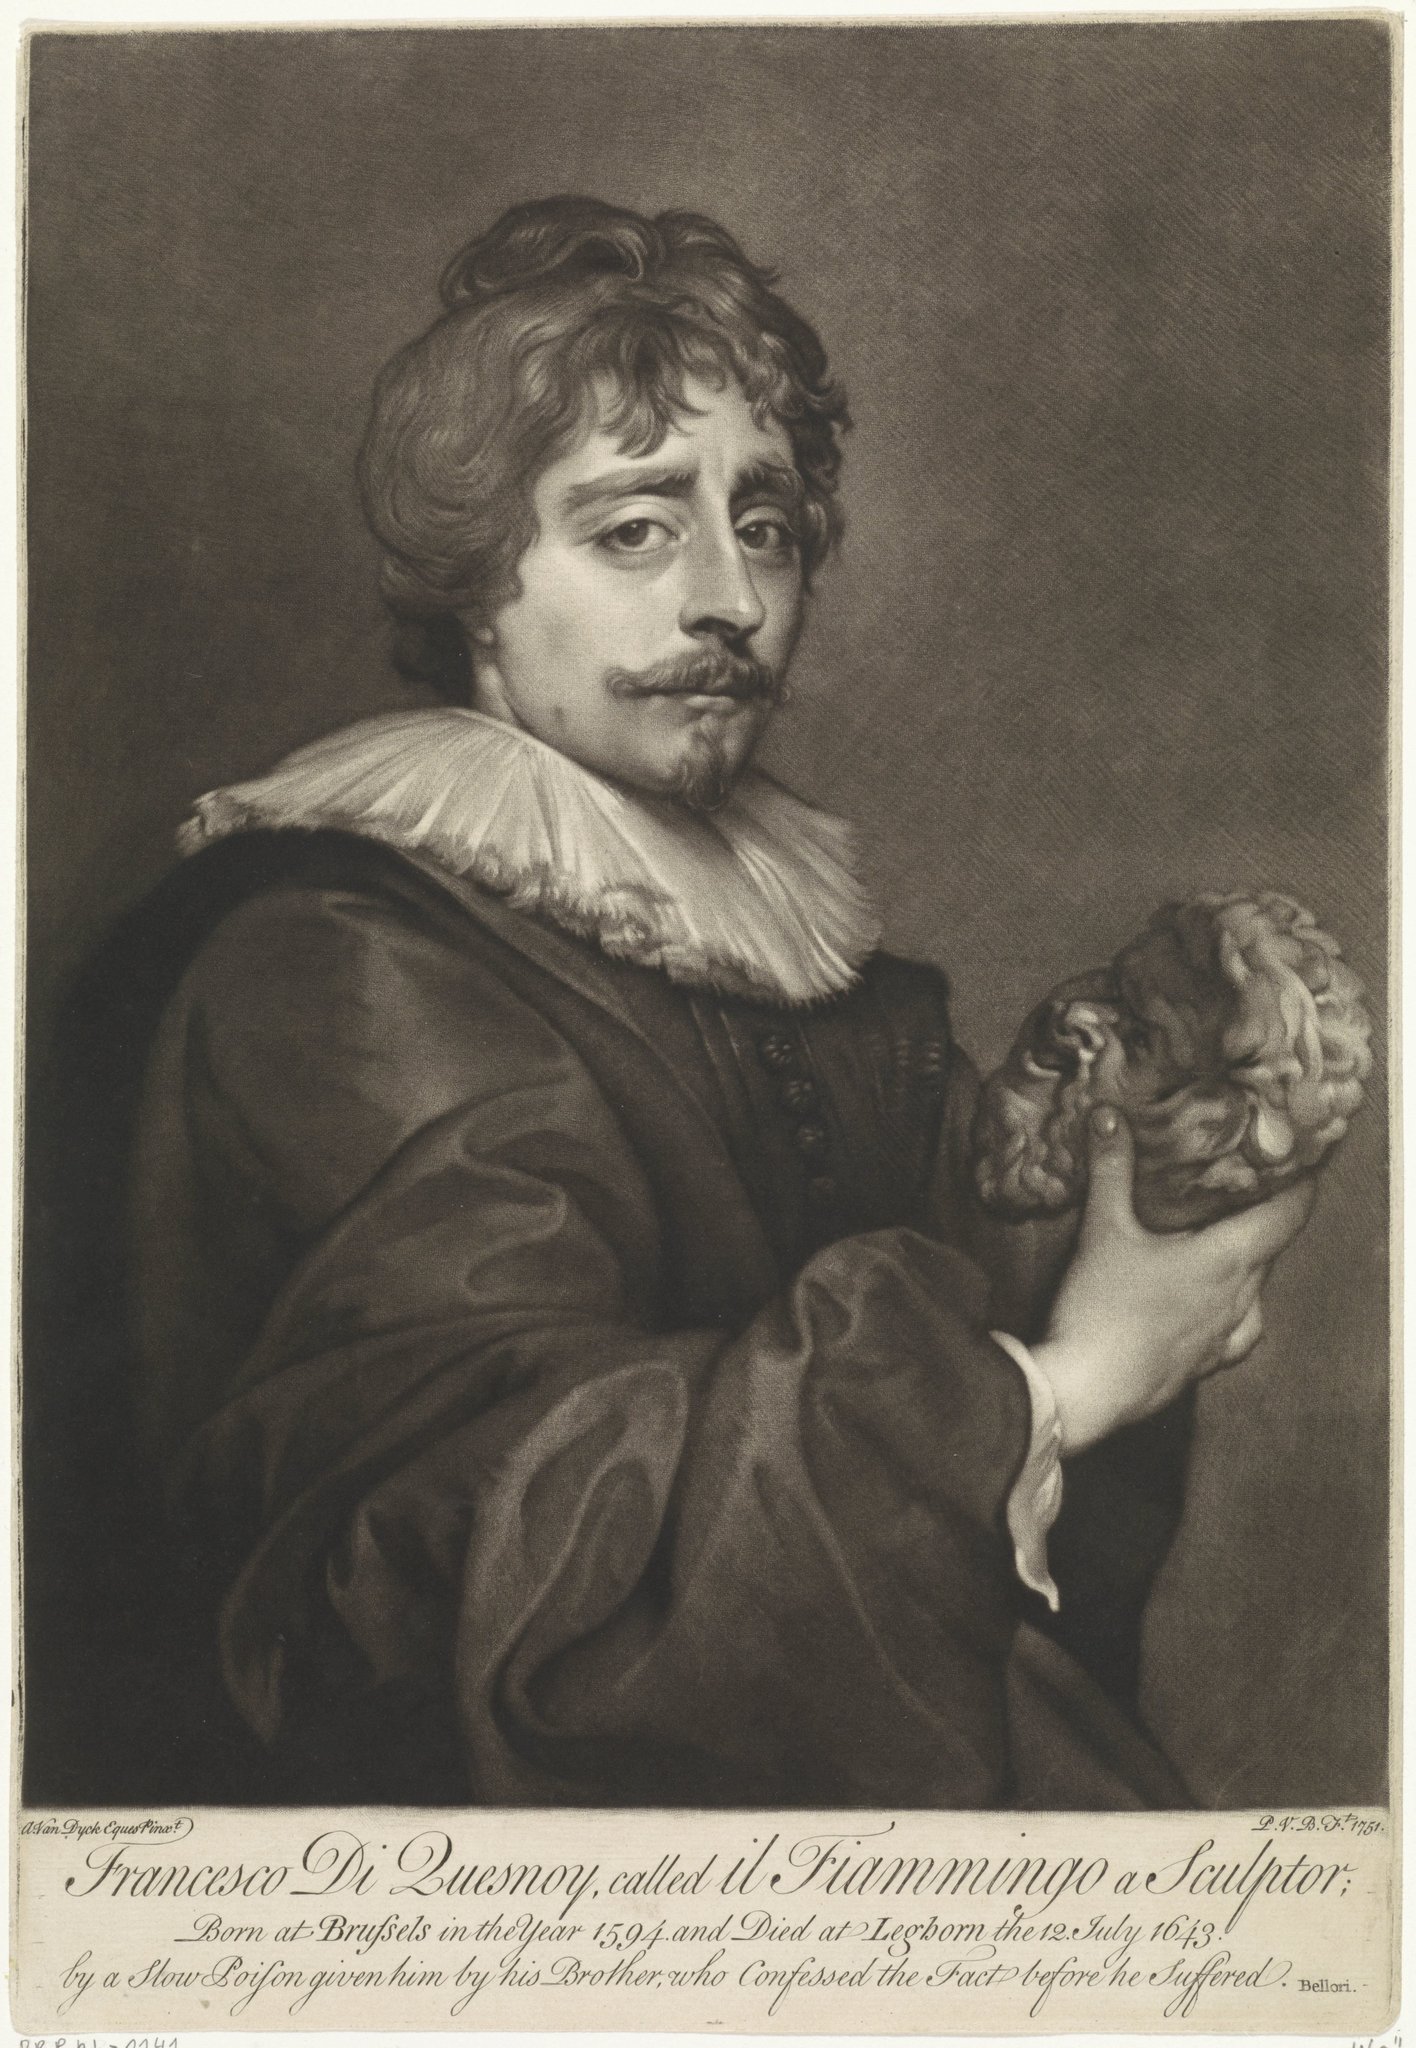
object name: print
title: Portret van François Duquesnoy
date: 1751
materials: paper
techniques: engraving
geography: england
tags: brussels, sculptor, françois du quesnoy, portrait, self-portrait of sculptor, historical persons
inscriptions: collector's mark: Lugt 240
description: Portret van de beeldhouwer François Duquesnoy. In zijn hand een gebeeldhouwde kop van een sater.